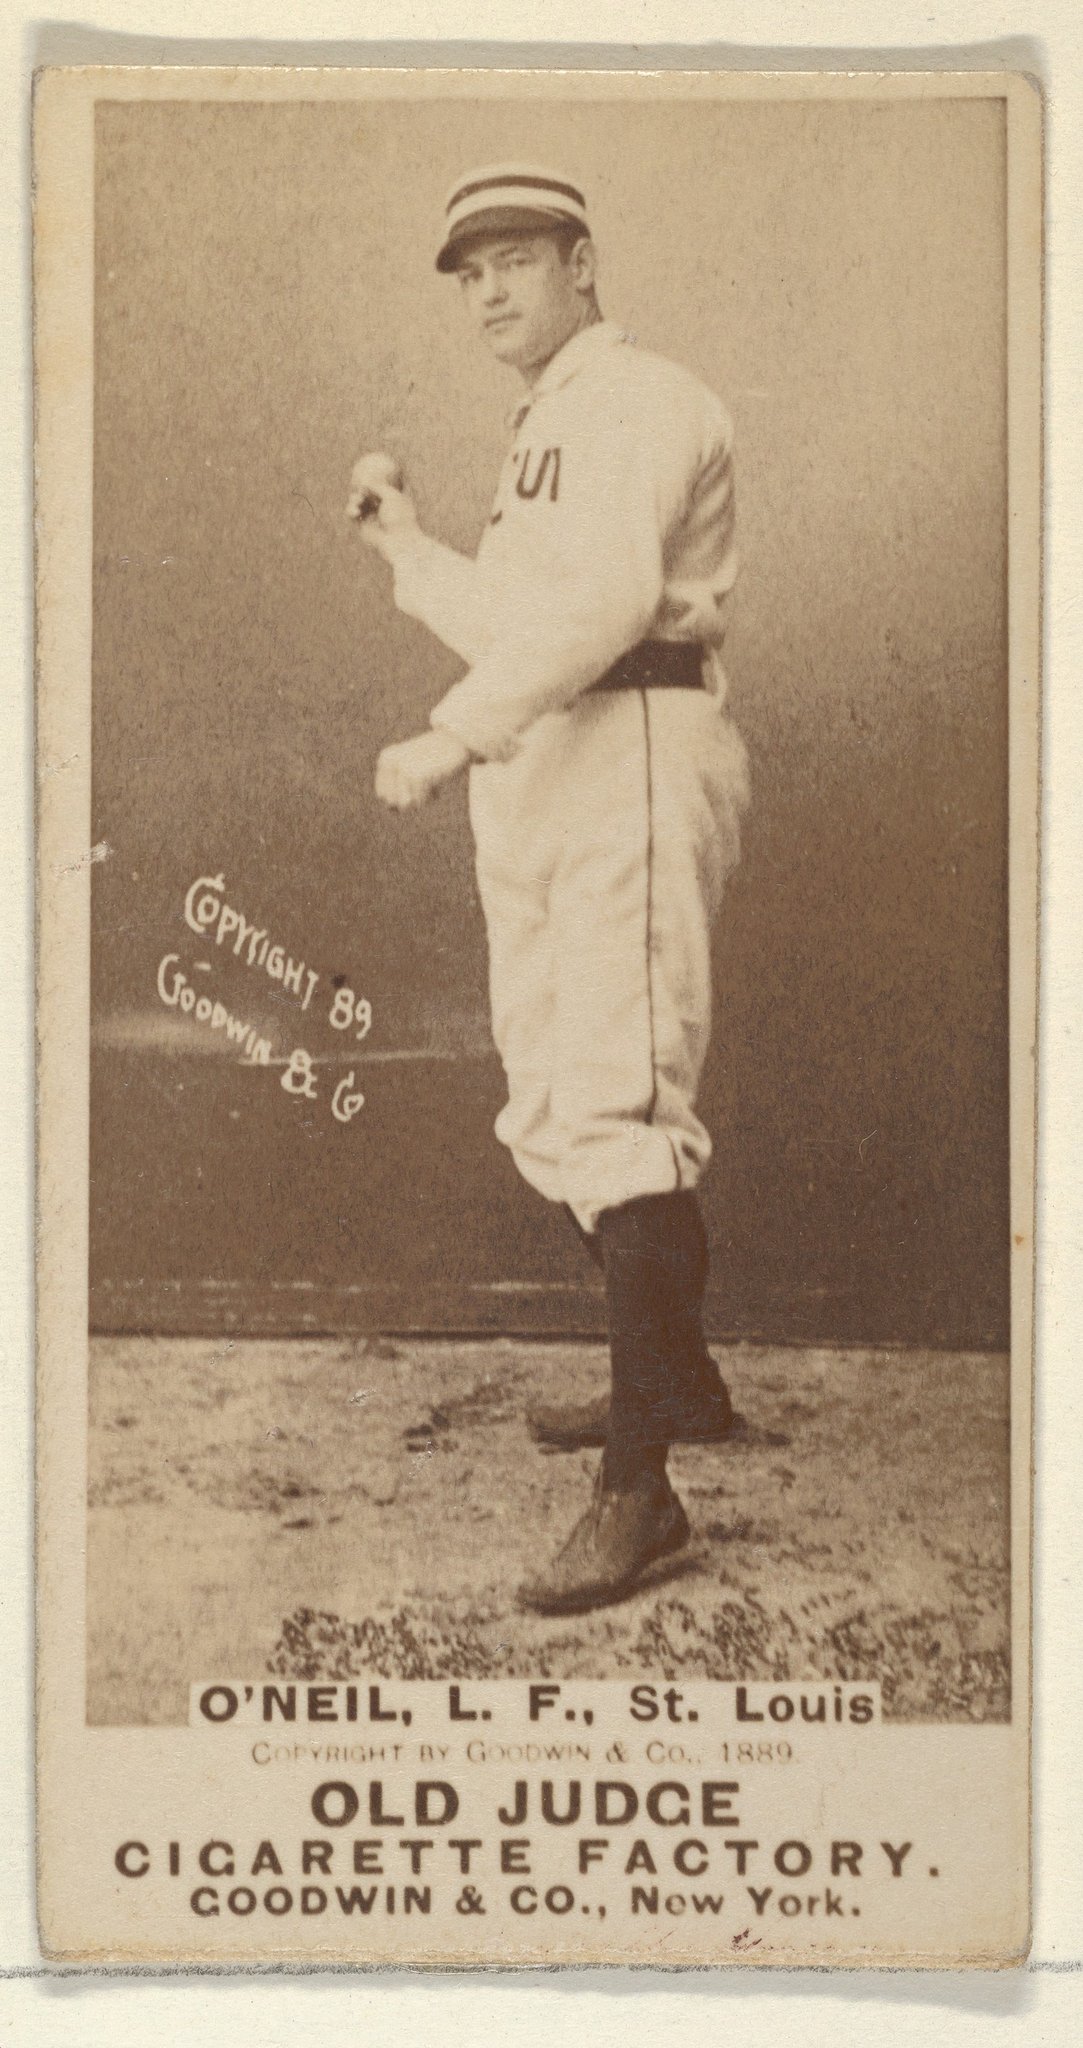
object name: baseball card, photograph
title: James Edward "Tip" O'Neill, Left Field, St. Louis Browns, from the Old Judge series (N172) for Old Judge Cigarettes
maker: goodwin & company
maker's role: publisher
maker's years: 1850-1950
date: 1889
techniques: albumen silver print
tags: men,portraits,baseball,athletes